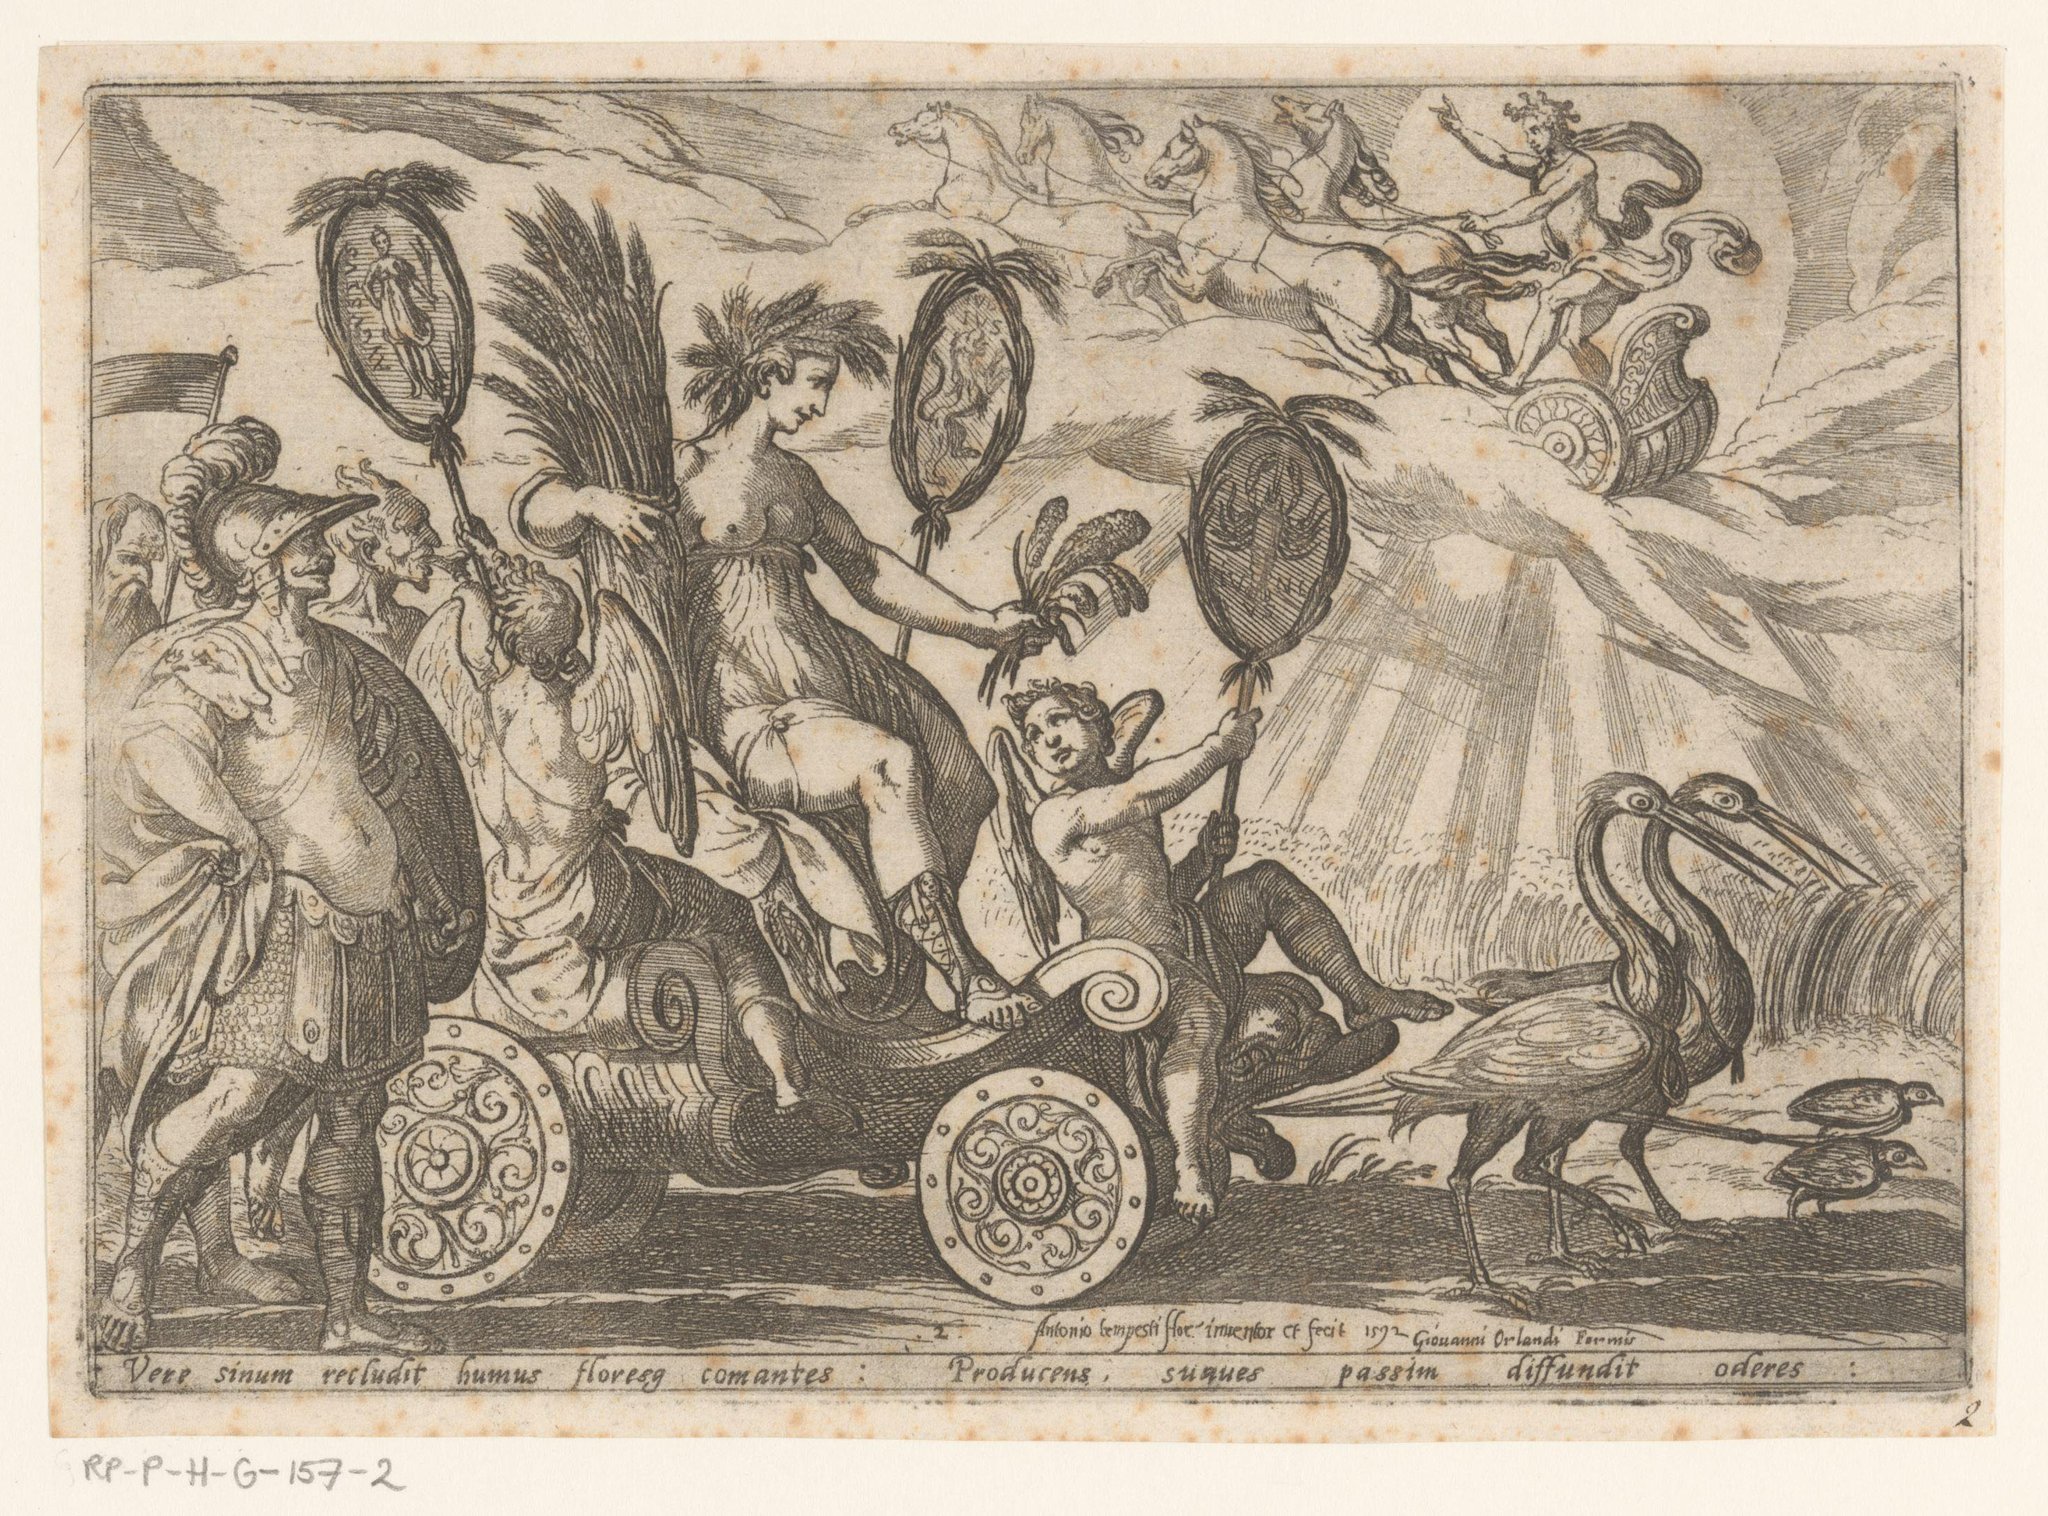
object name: print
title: Zomer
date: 1592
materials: paper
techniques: etching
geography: rome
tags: the chariot of the sun, summer, 'aestas'; 'estate' (ripa)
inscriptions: number: ‘2’, collector's mark: ‘Hinloopen’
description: De vrouwelijke personificatie van de zomer met graan en bloemen op een wagen die wordt voortgetrokken door vogels. Apollo rijdt op zijn zonnewagen door de lucht. Titel in het Latijn in de ondermarge.